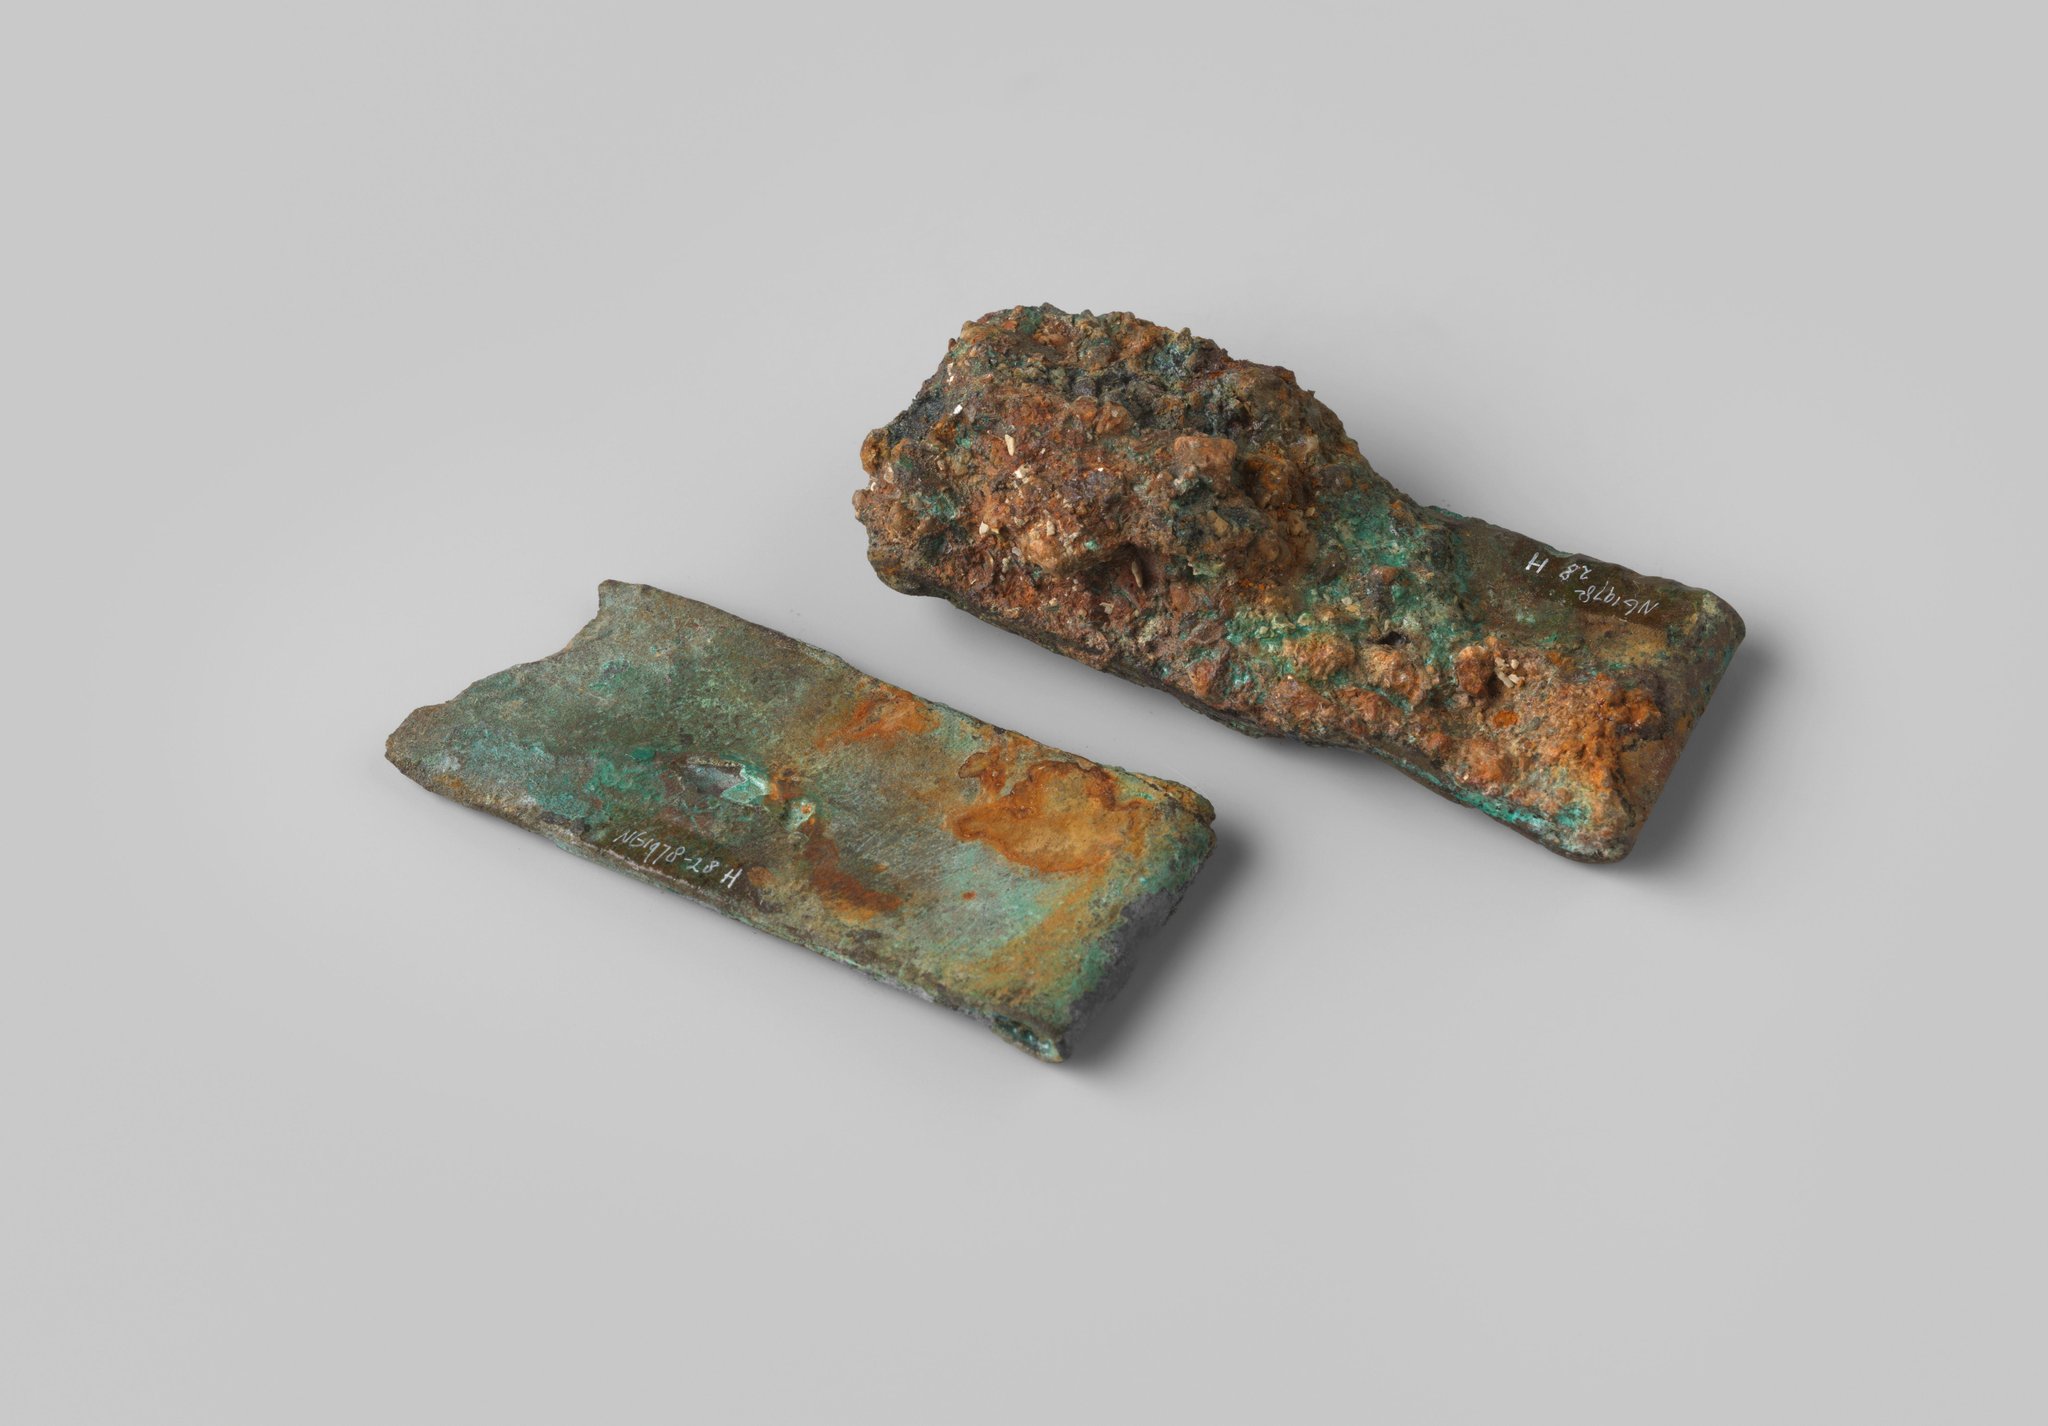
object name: firehose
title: Twee fragmenten van een brandslangring uit het wrak van de Oost-Indiëvaarder Hollandia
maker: Anonymous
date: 1700-1743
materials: copper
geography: netherlands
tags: verenigde oostindische compagnie, hollandia (schip), annet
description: Fire engine, firehose; fragments, id. NG-1975-20-H-1271-A, squashed.